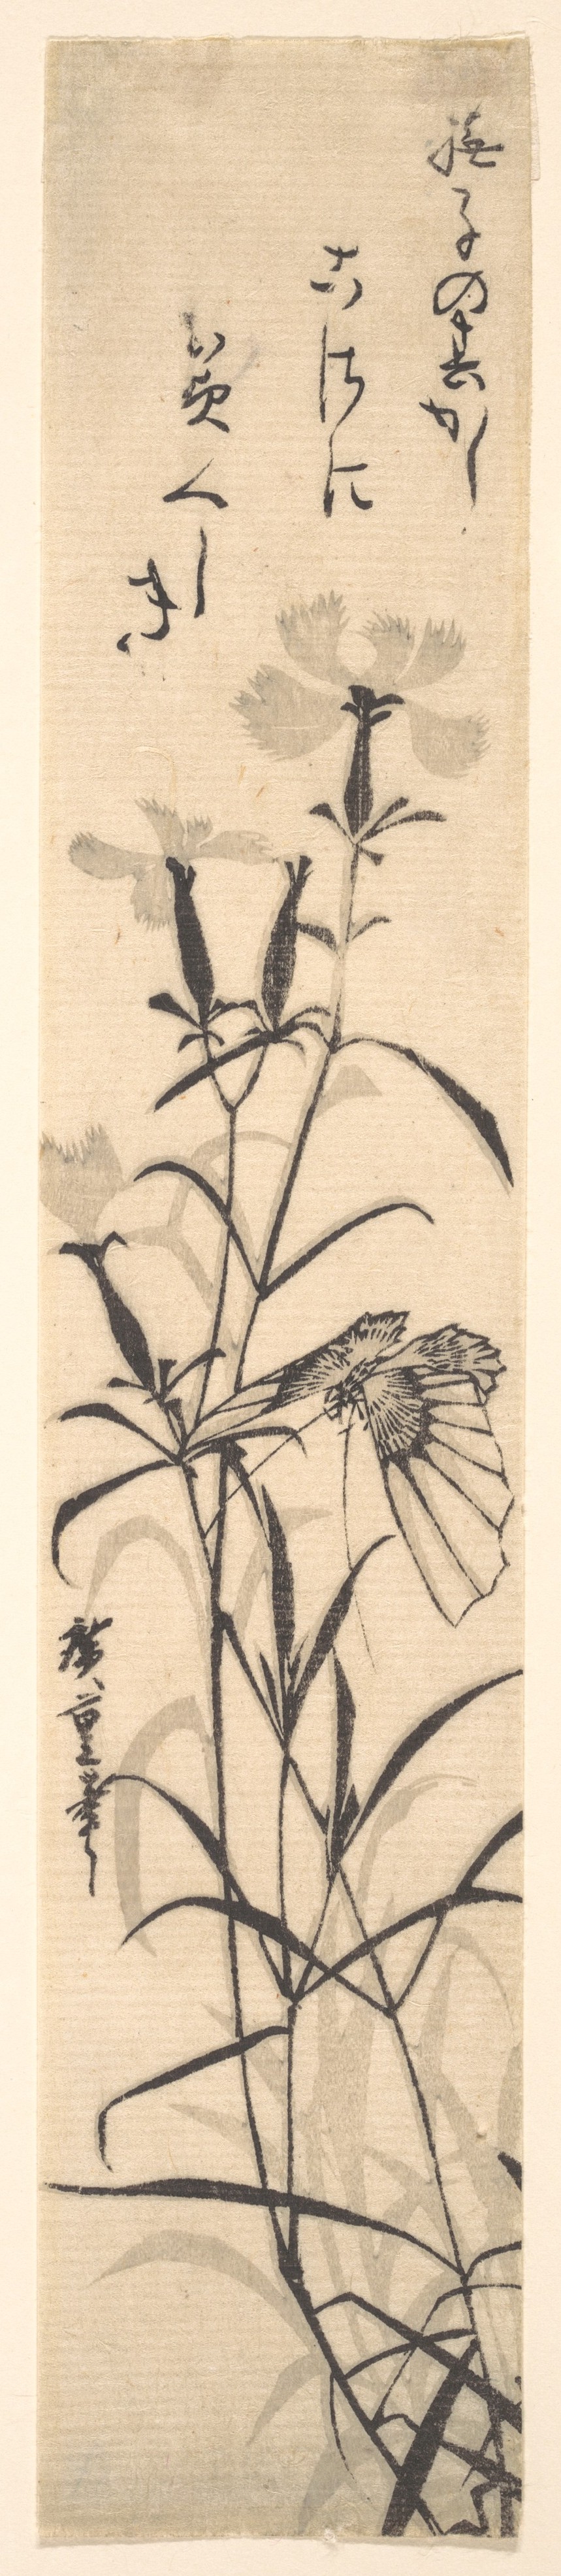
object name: print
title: Black and White Print of Butterfly and Flower (a Pink)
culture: japanese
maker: utagawa hiroshige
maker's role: artist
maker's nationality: japanese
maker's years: 1797-1858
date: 1797-1858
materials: ink, paper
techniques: woodblock print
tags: butterflies,flowers